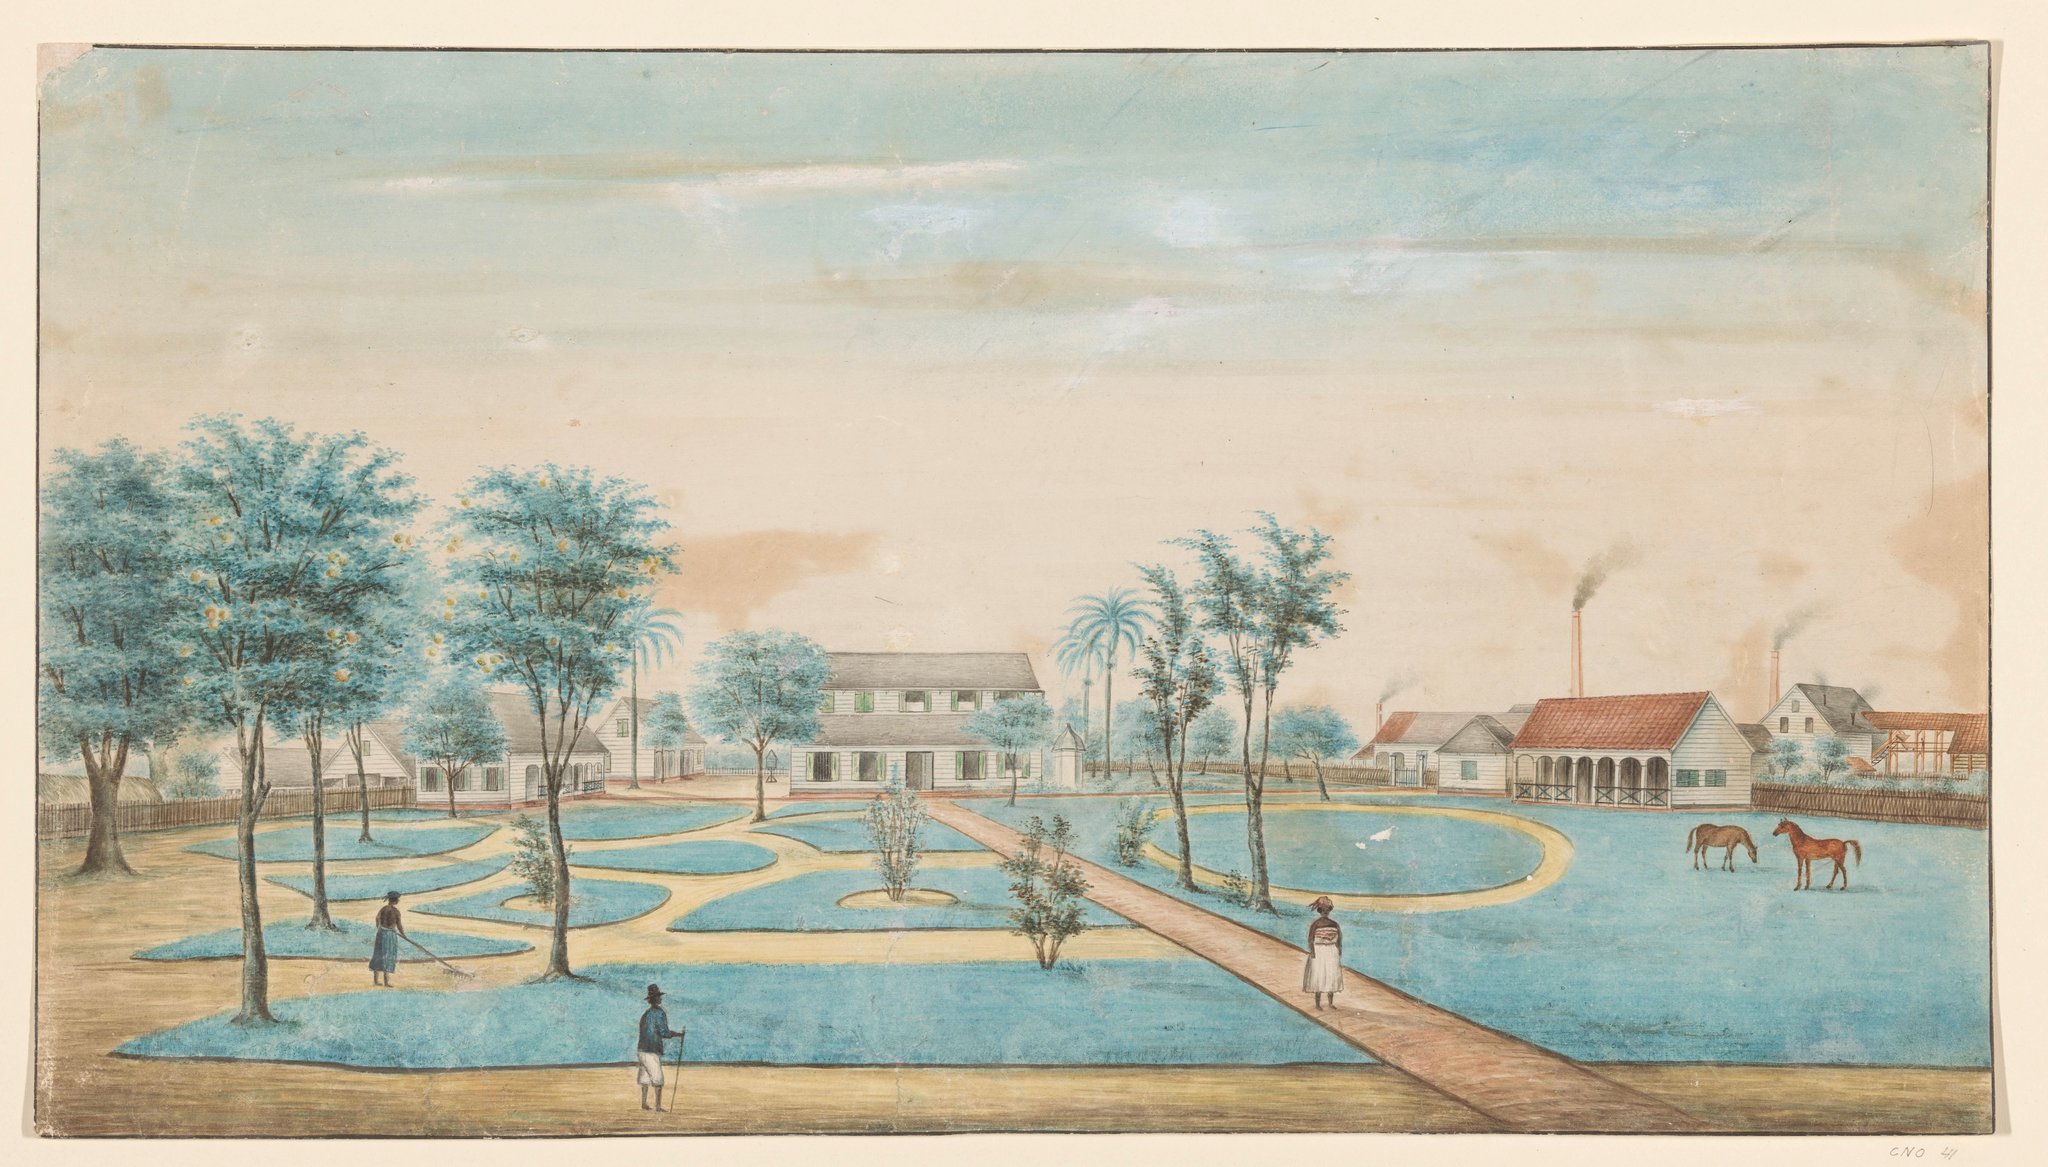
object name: drawing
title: Gezicht op de suikerplantage Catharina Sophia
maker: alexander ludwich brockmann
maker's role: draughtsman, painter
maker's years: -1866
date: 1860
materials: ink, paper, watercolor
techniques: brush, pen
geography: suriname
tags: plantation, factory-building, horse, suriname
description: Gezicht op de tuin behorende bij de plantage. Rechts staat een fabriek.